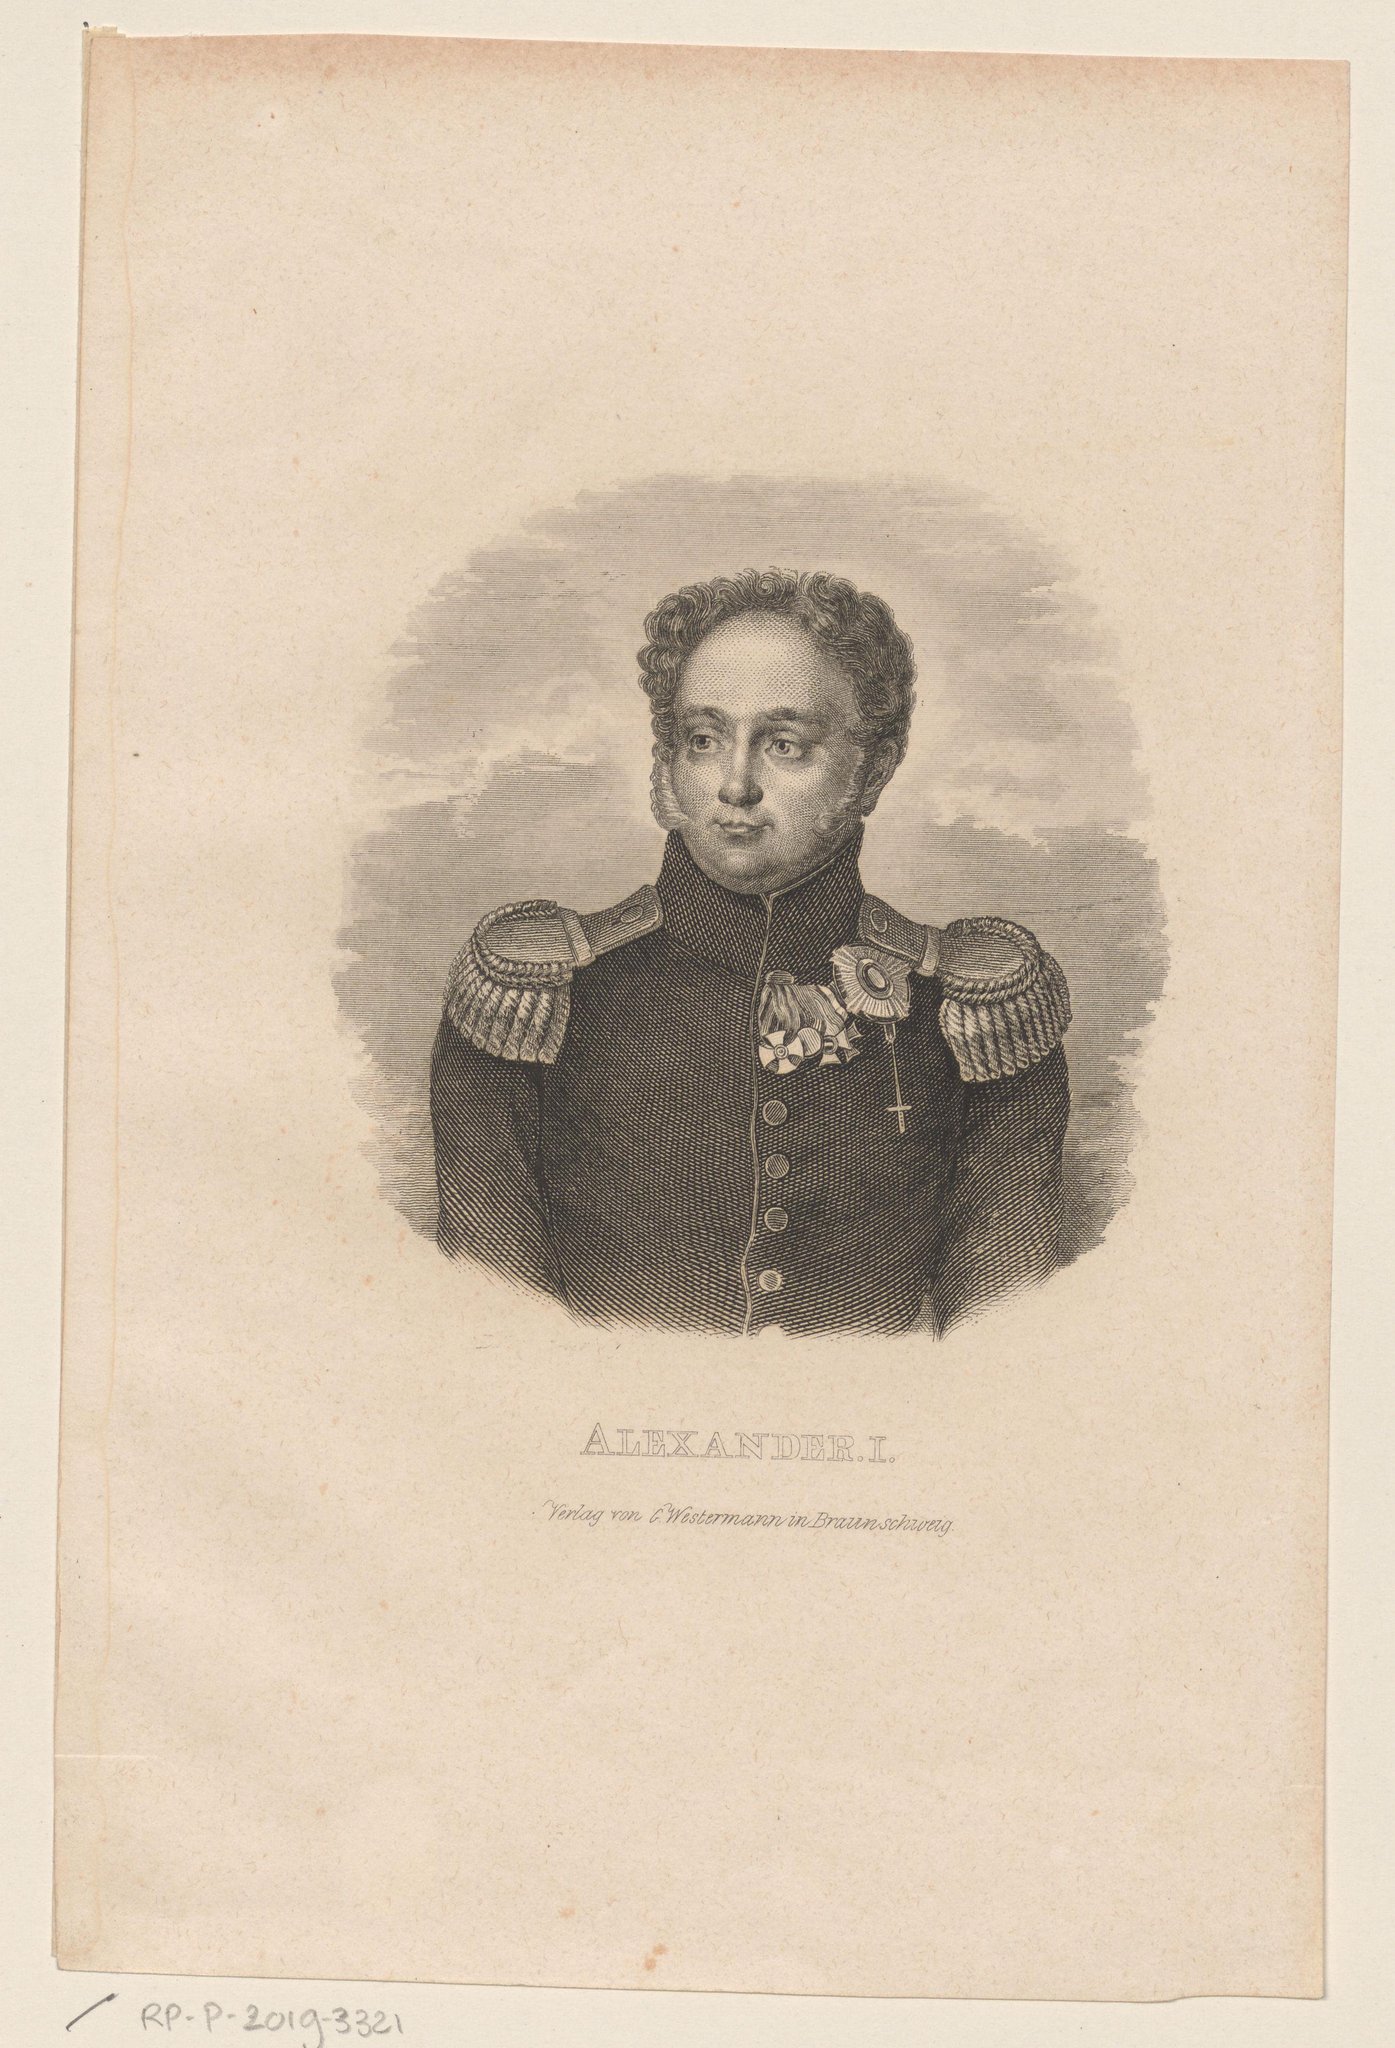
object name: print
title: Portret van Alexander I, tsaar van Rusland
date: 1838-1879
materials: paper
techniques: engraving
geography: braunschweig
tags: alexander i (tsaar van rusland), historical persons, emperor